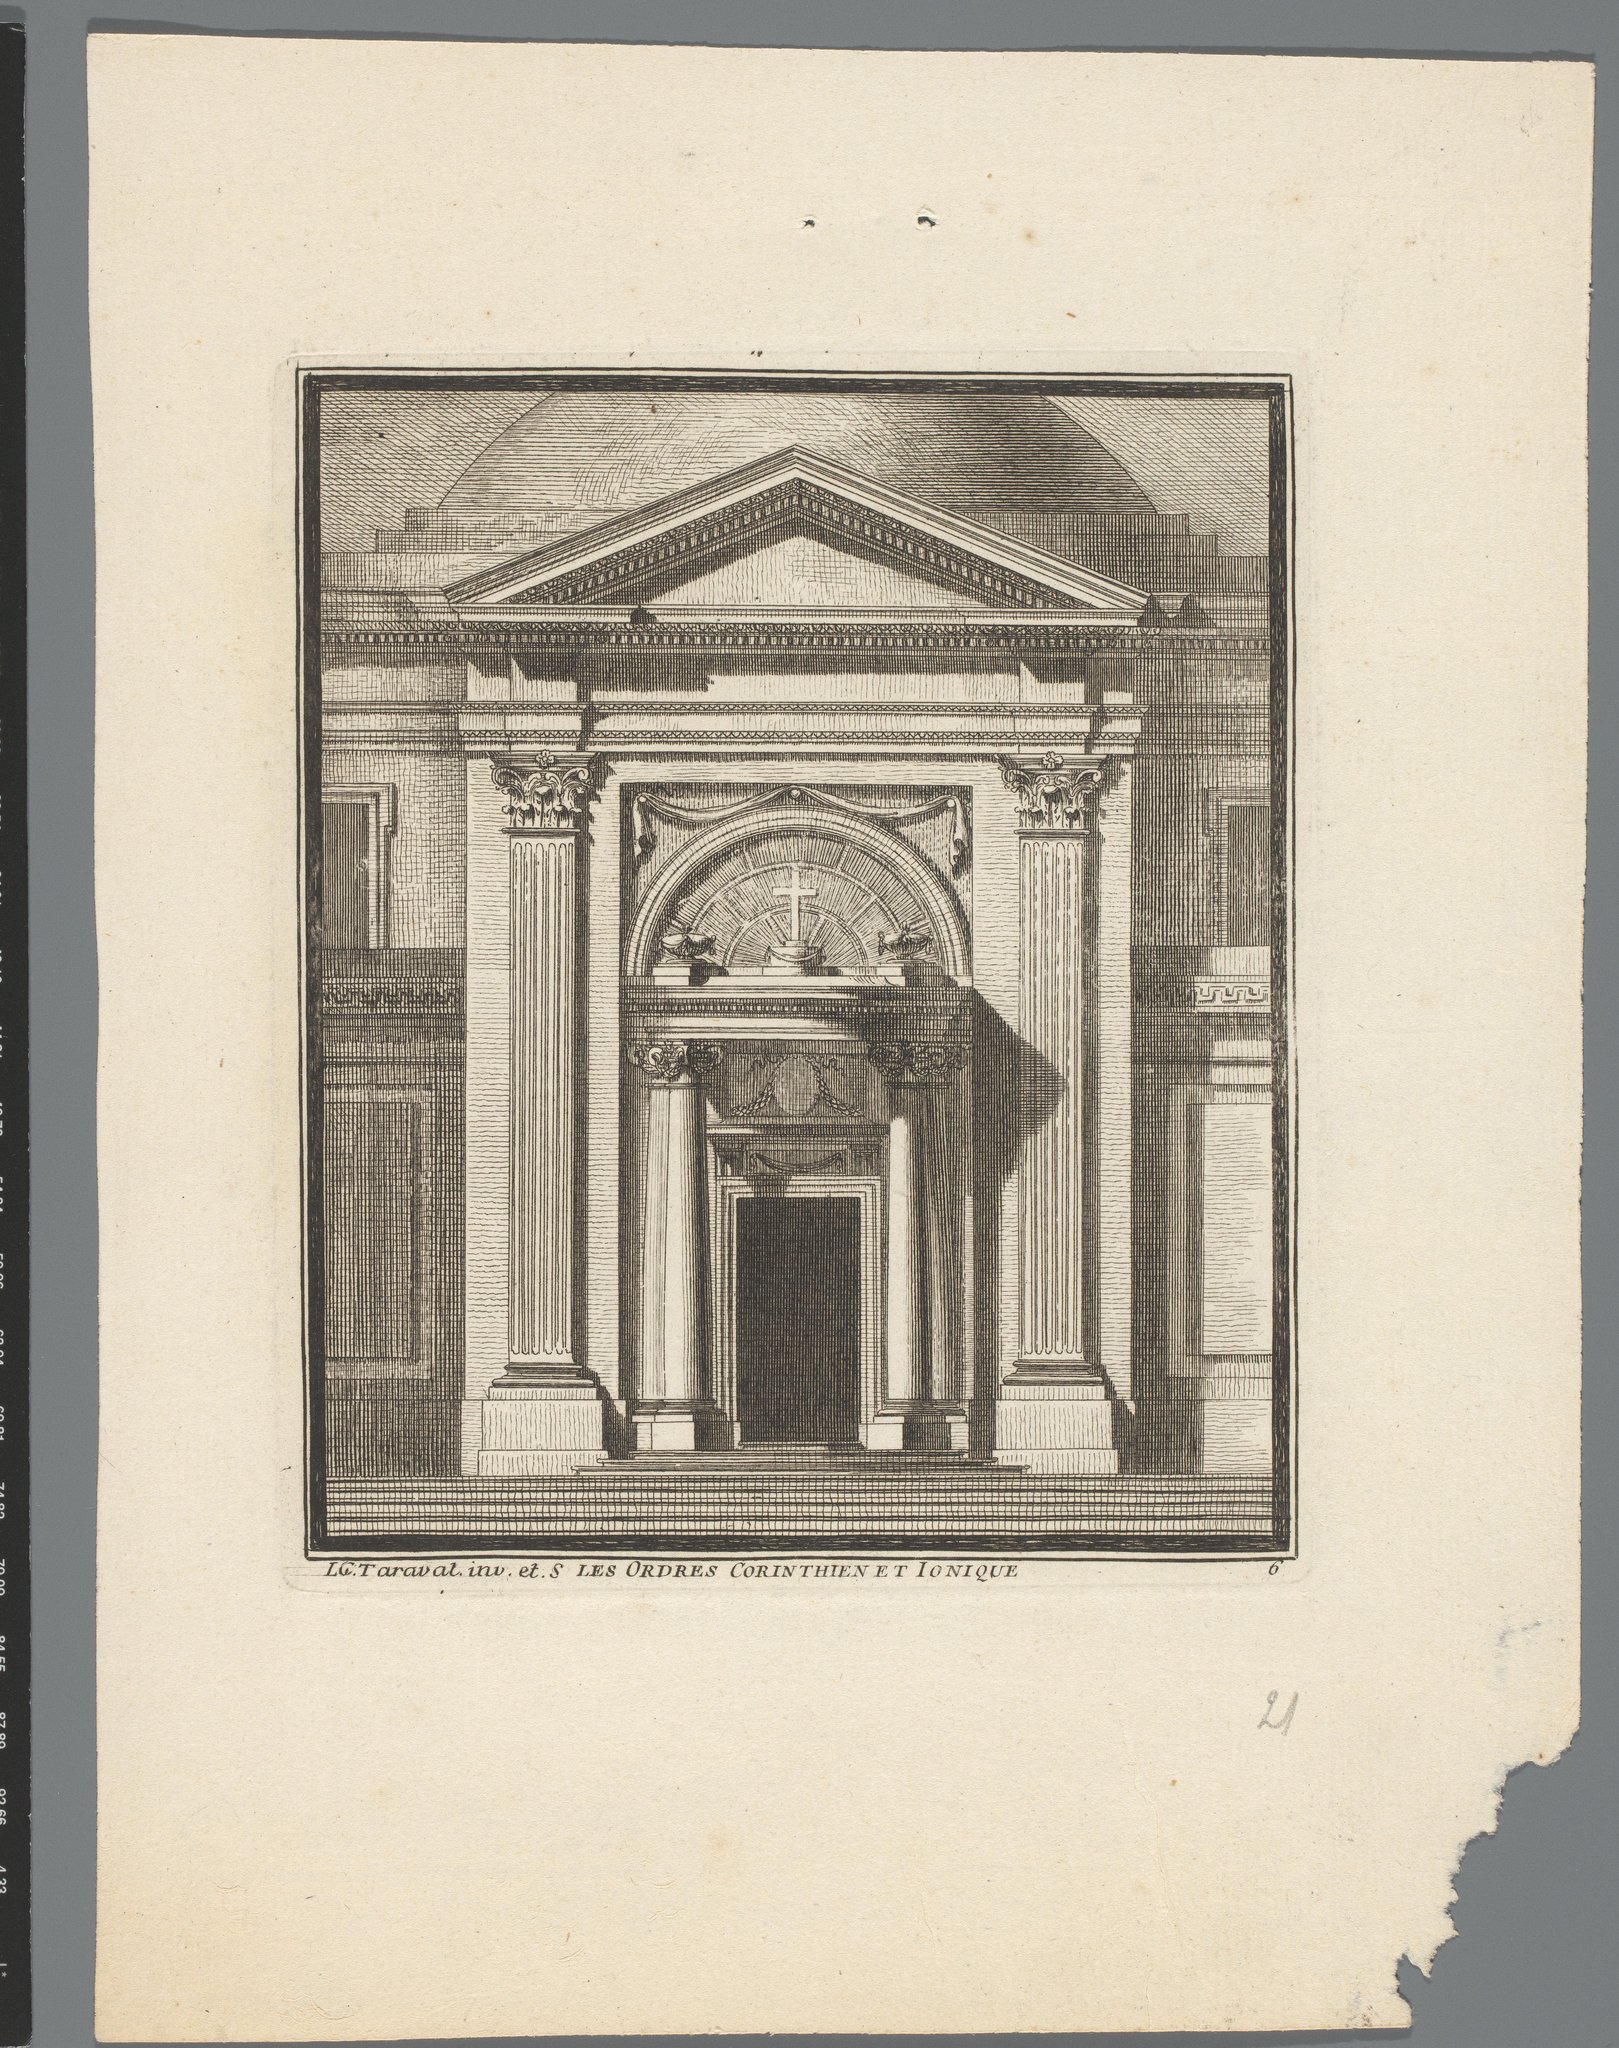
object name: print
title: Plusieurs Portails Et Portes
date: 1768-1786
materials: paper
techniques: etching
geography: paris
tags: monumental door, porch, 'aediculum', ionic order ~ architecture, corinthian order ~ architecture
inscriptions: collector's mark: Lugt 2228, collector's mark: Lugt 2760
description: Een portaal met Ionische zuilen, Korinthische pilasters en een rondboog met twee vazen en een kruis. Aan de bovenzijde een driehoekig fronton voor een koepel.